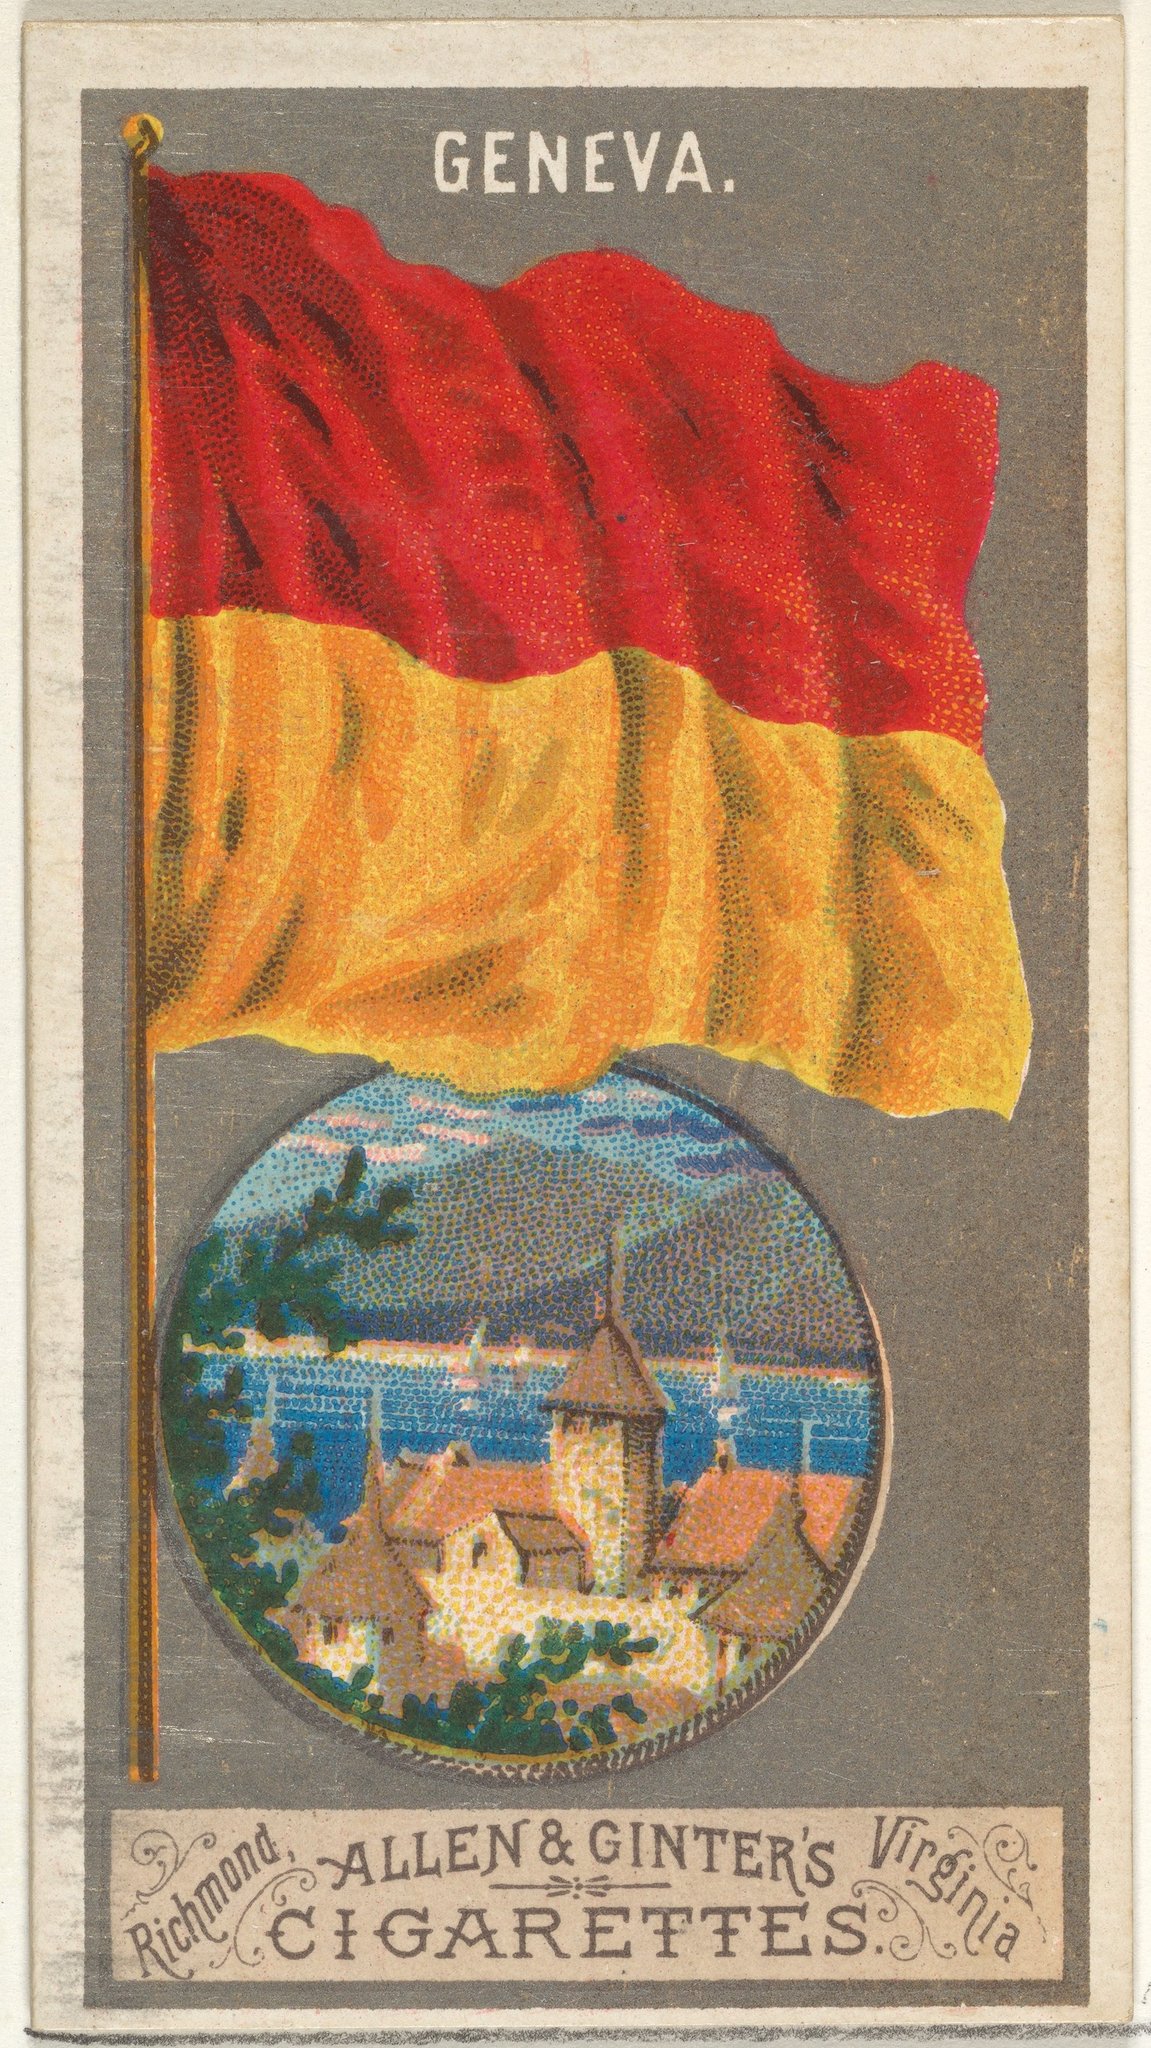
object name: print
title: Geneva, from the City Flags series (N6) for Allen & Ginter Cigarettes Brands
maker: allen & ginter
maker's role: publisher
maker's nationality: american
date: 1887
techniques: color lithograph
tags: flags